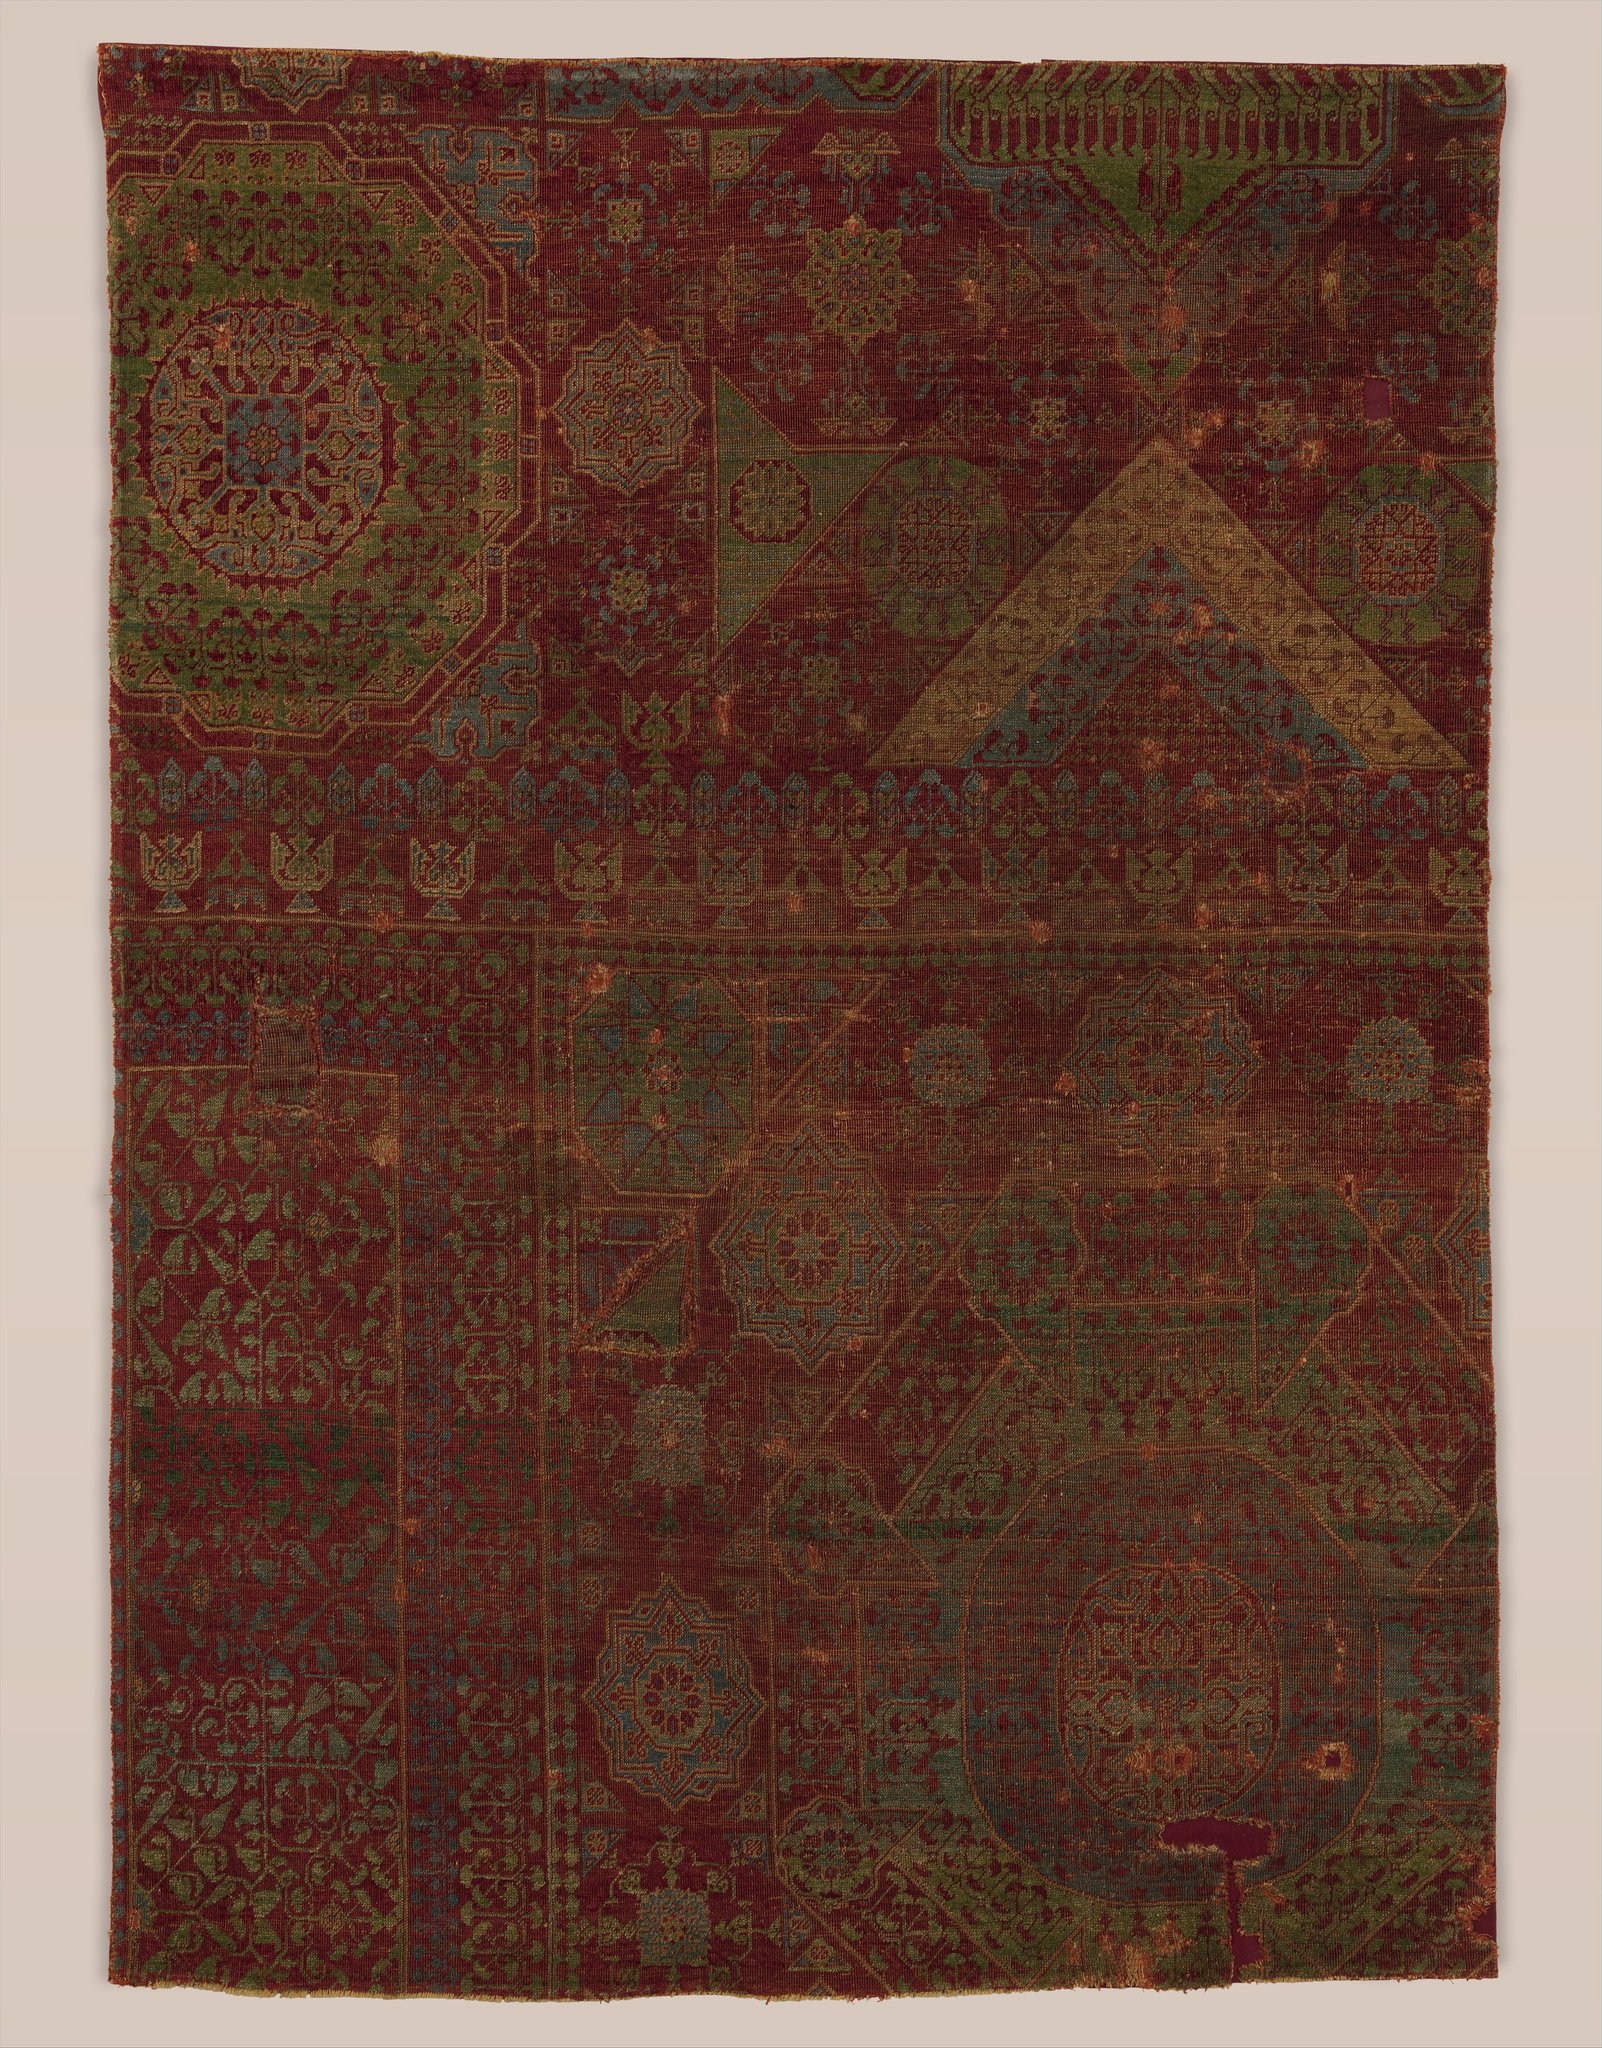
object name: carpet fragment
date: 1576-1600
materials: wool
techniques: asymmetrically knotted pile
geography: egypt